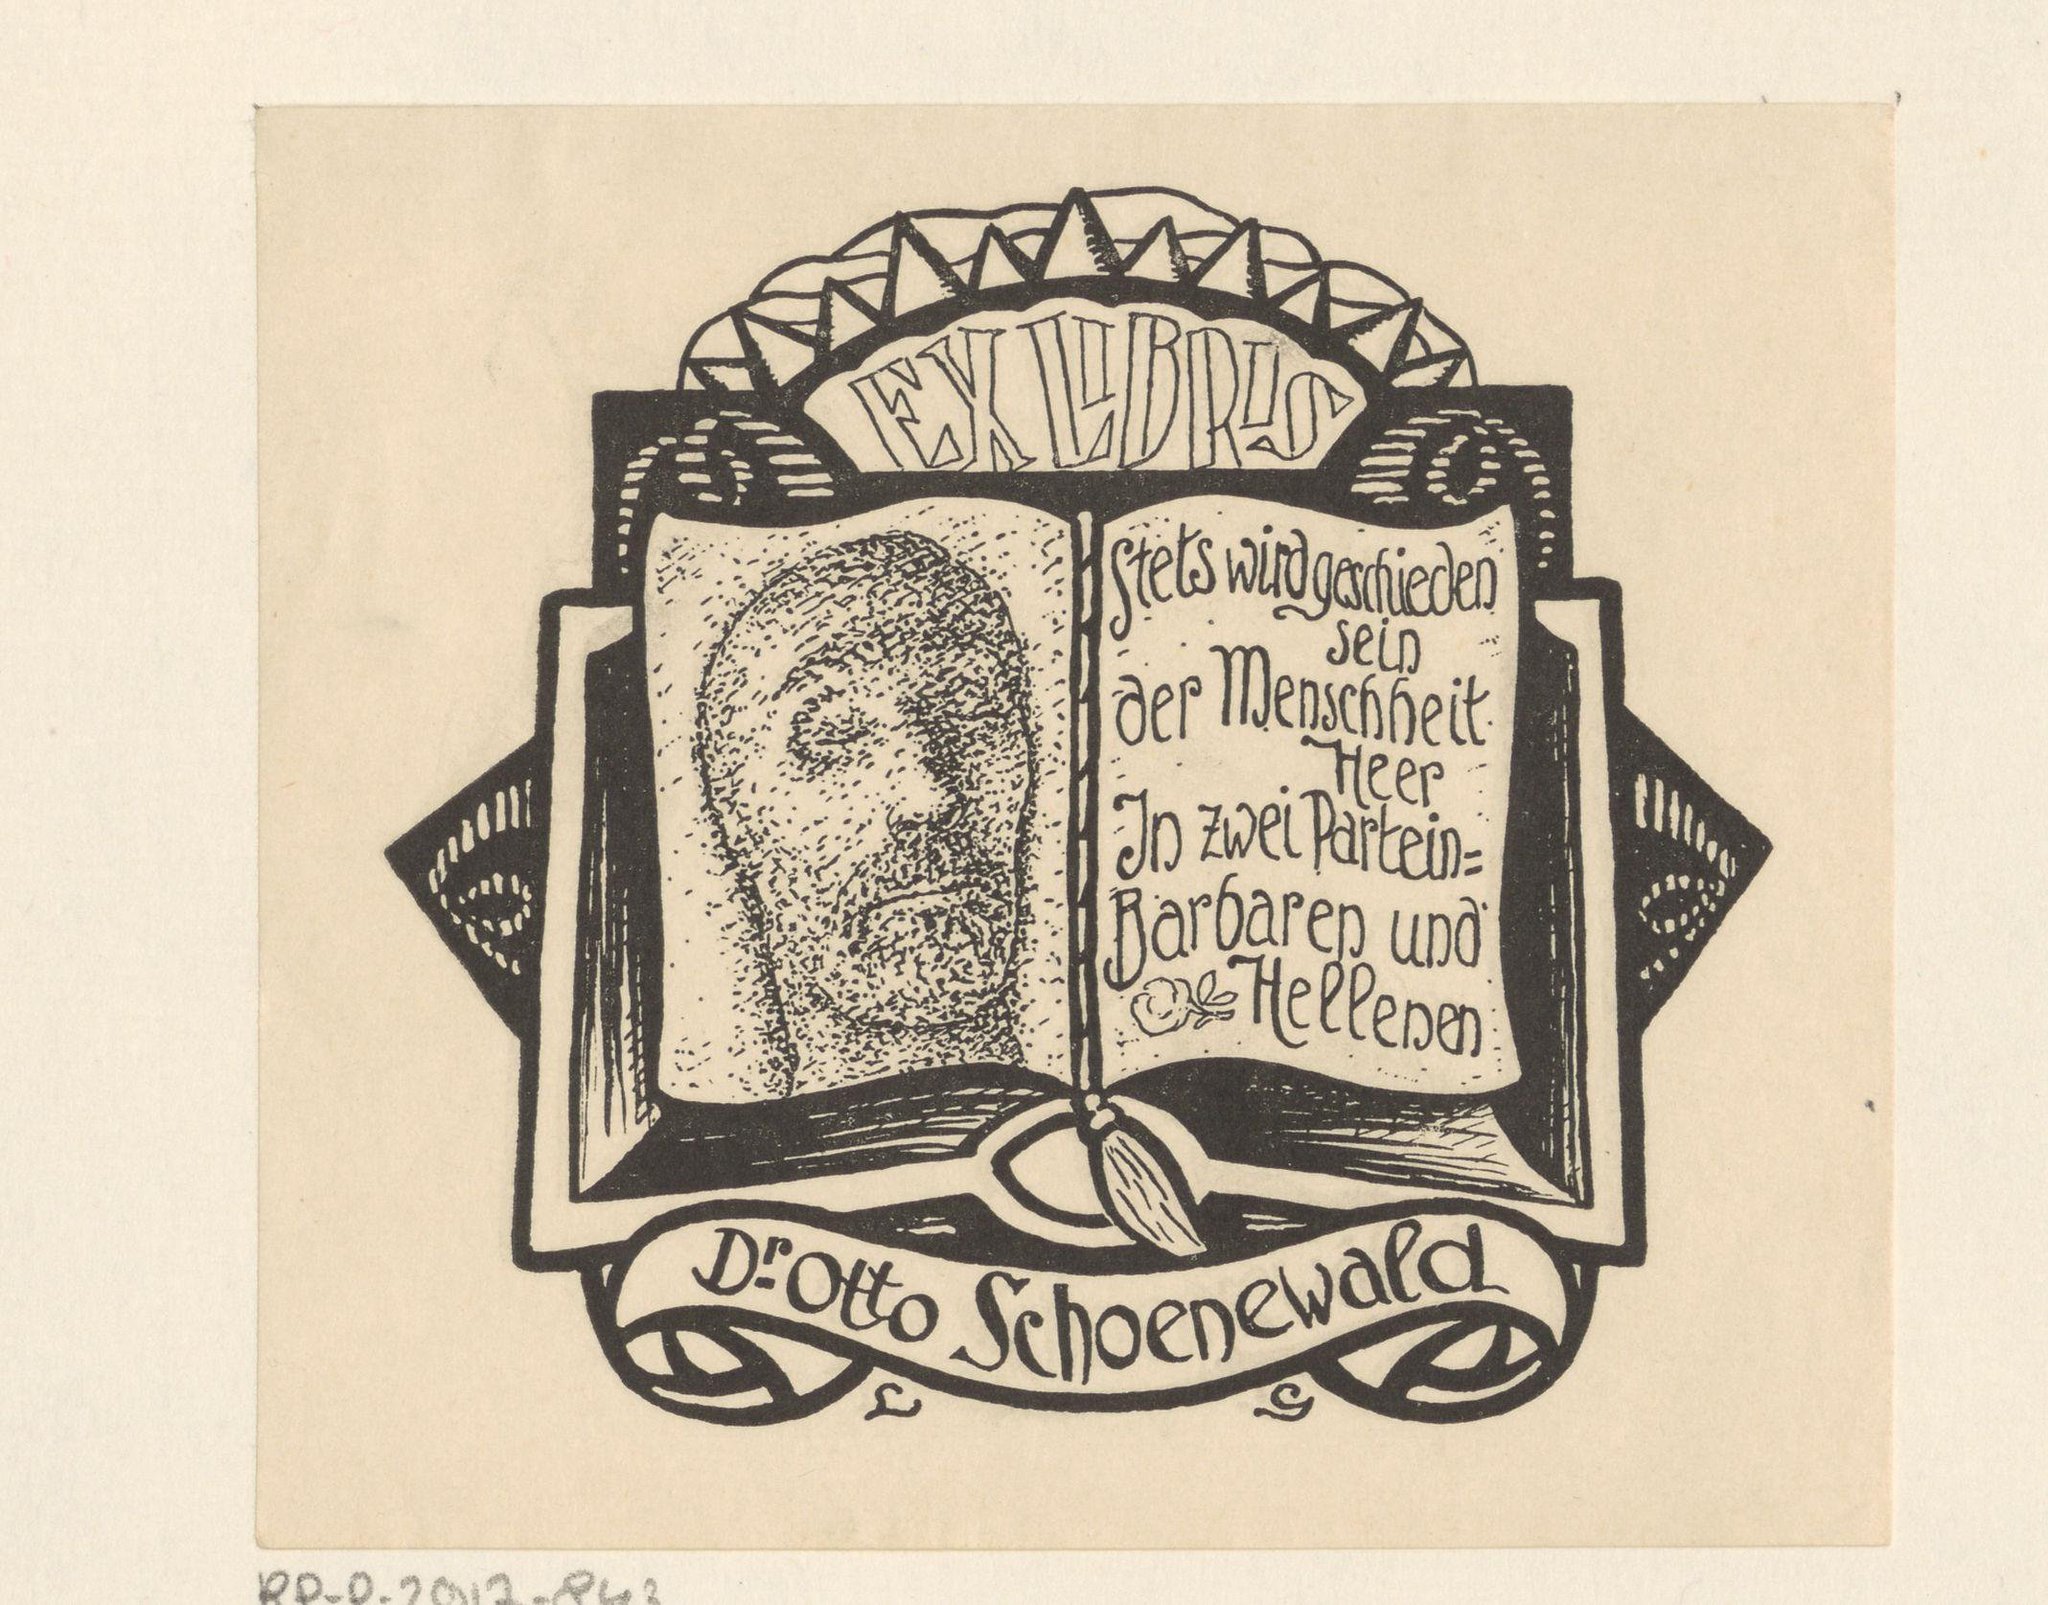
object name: bookplate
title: Ex libris van Otto Schoenewald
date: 1937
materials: paper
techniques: printing block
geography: netherlands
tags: death-mask, book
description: Ontwerpen voor dit ex libris bevinden zich in de collectie van het Rijksprentenkabinet (RP-T-1960-806) en de Rijksdienst Cultureel Erfgoed (inv. no. R11316 en R11311.